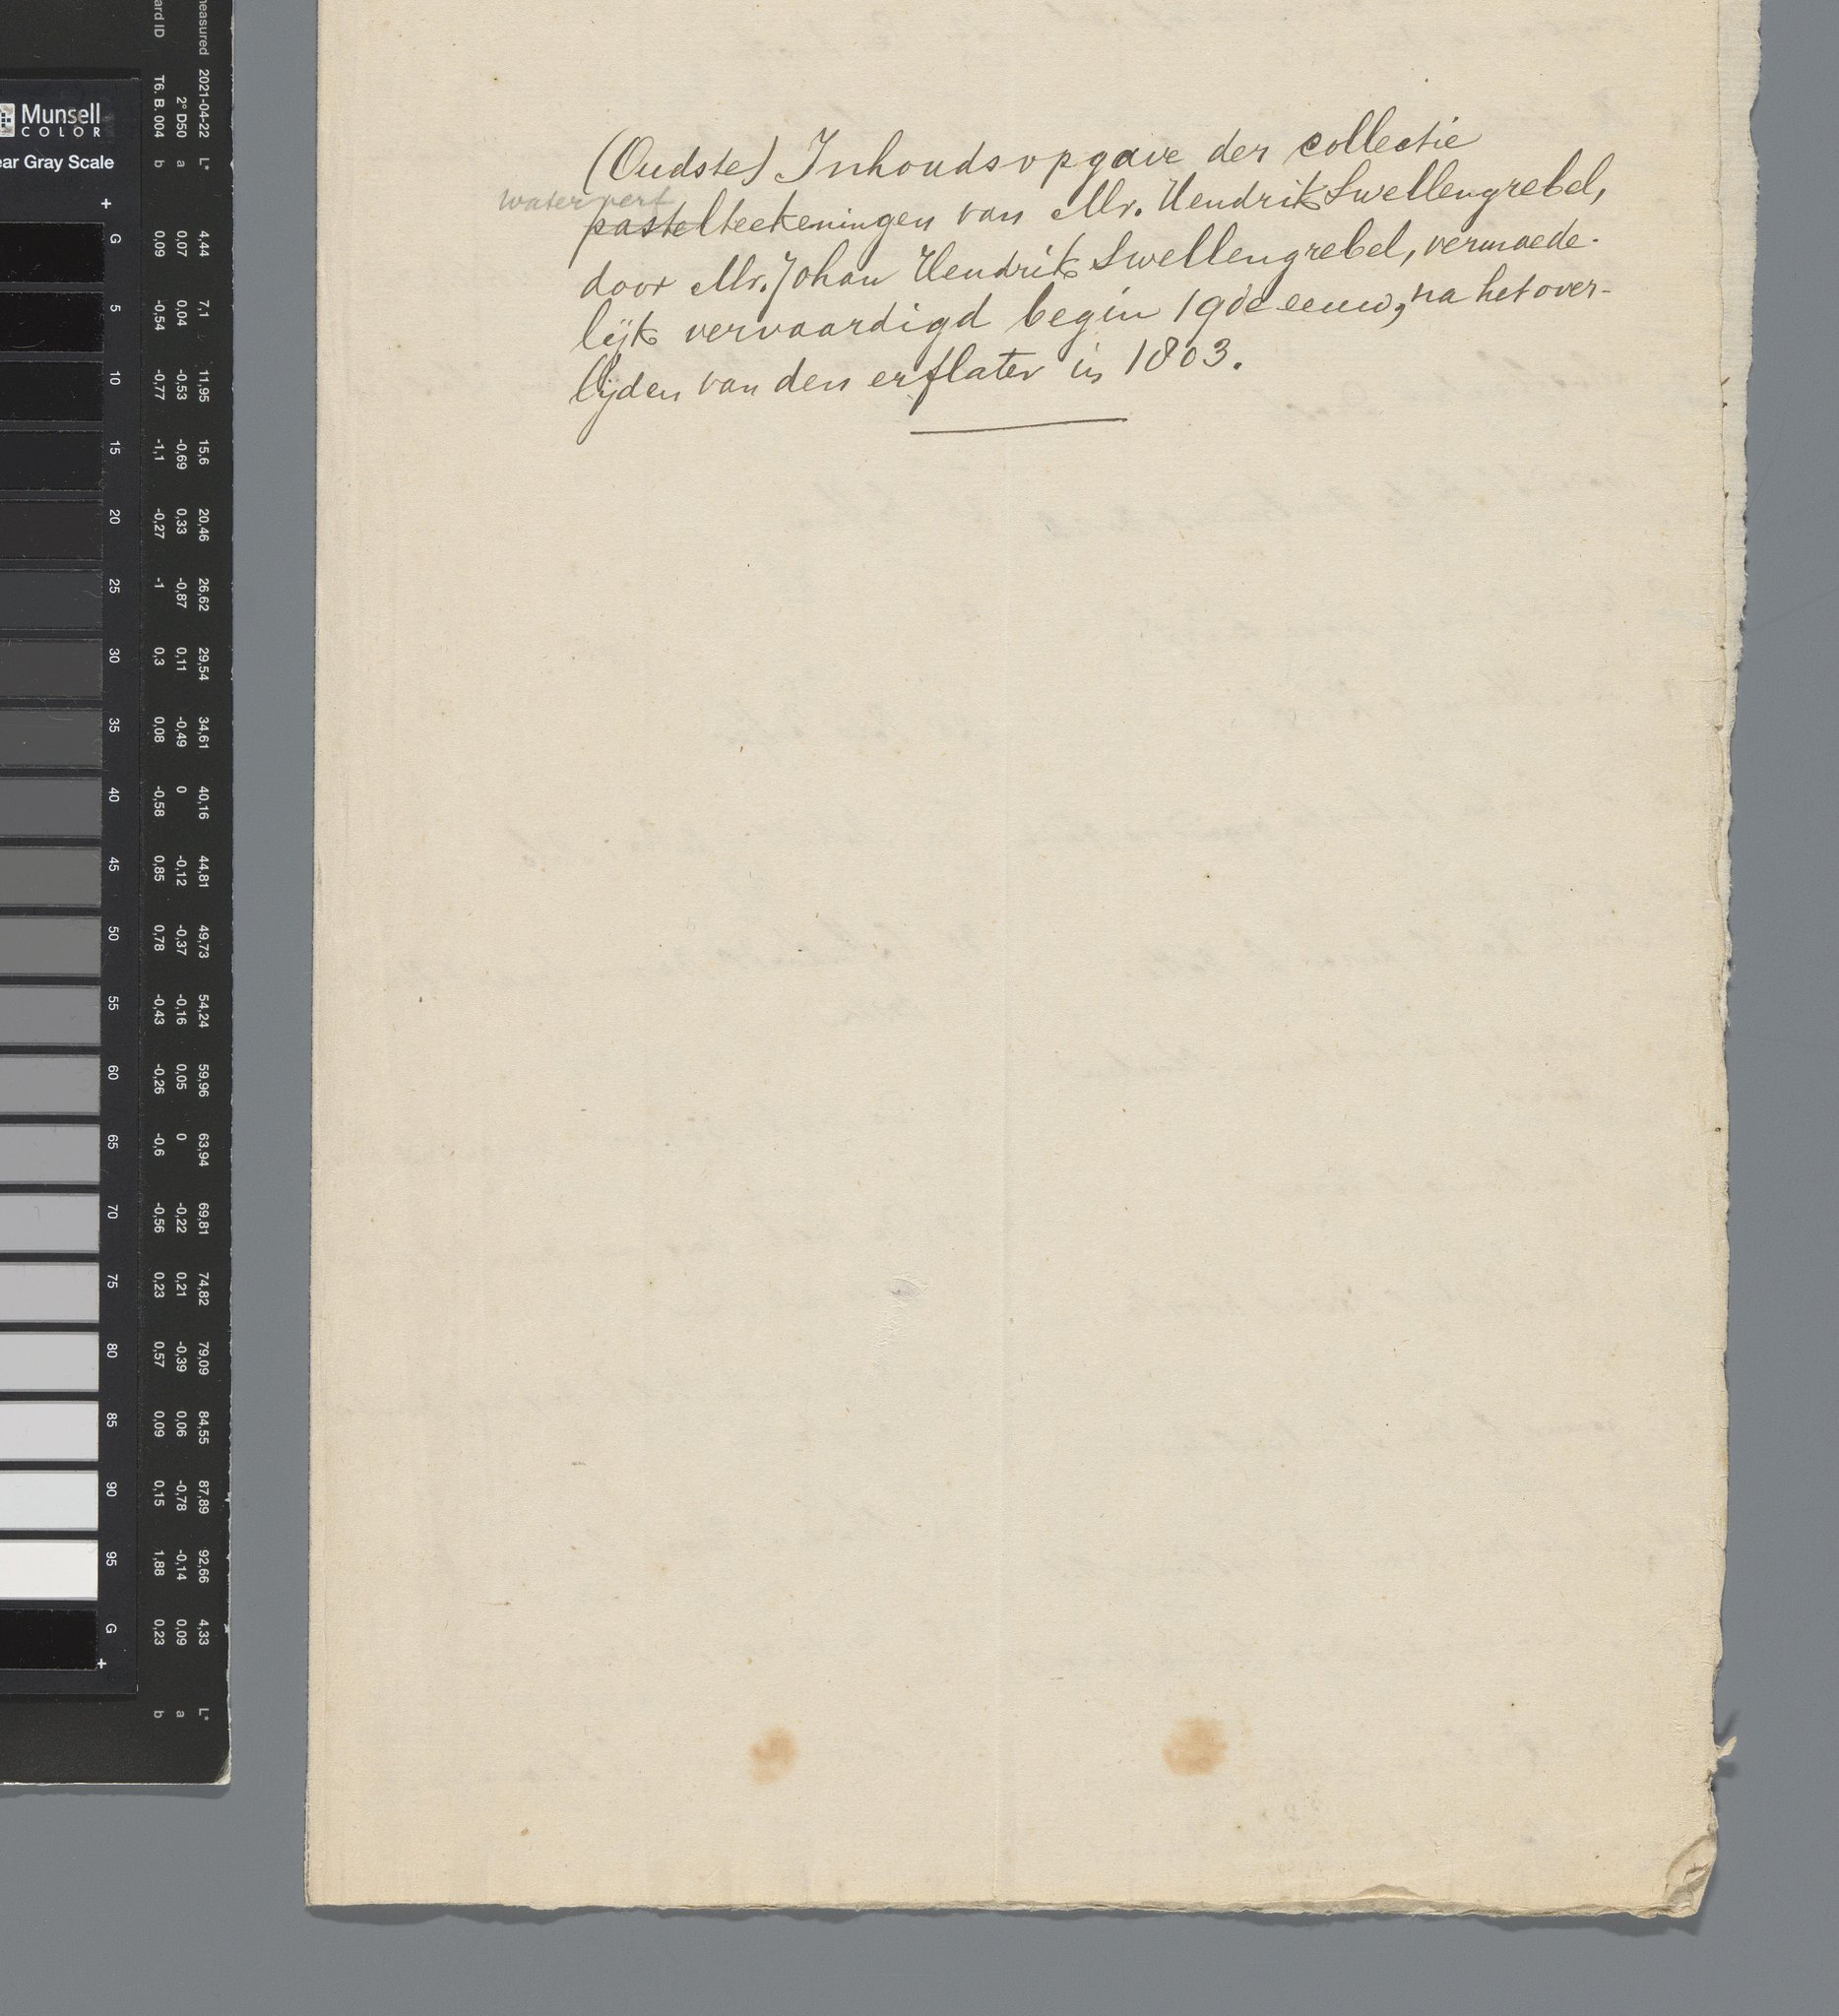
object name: table of content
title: Aquarellen betrekking hebbende op de drie reizen door de Kaap door Hendrik Swellengrebel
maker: johan hendrik swellengrebel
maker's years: 1757-1842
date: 1803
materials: ink, paper, pencil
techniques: pen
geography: south africa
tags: cape of good hope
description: Handgeschreven inhoudsopgave van de tekeningen in de Swellengebel collectie. Dubbelgevouwen blad met binnenin de lijst van de tekeningen genummerd 1-66 gemaakt tijdens de drie reizen van Hendrik Swellengrebel door de Kaapkolonie, tussen juli 1776 en januari 1777. Bij de lijst een los blaadje met notitie en een fotokopie van een andere moderne lijst.